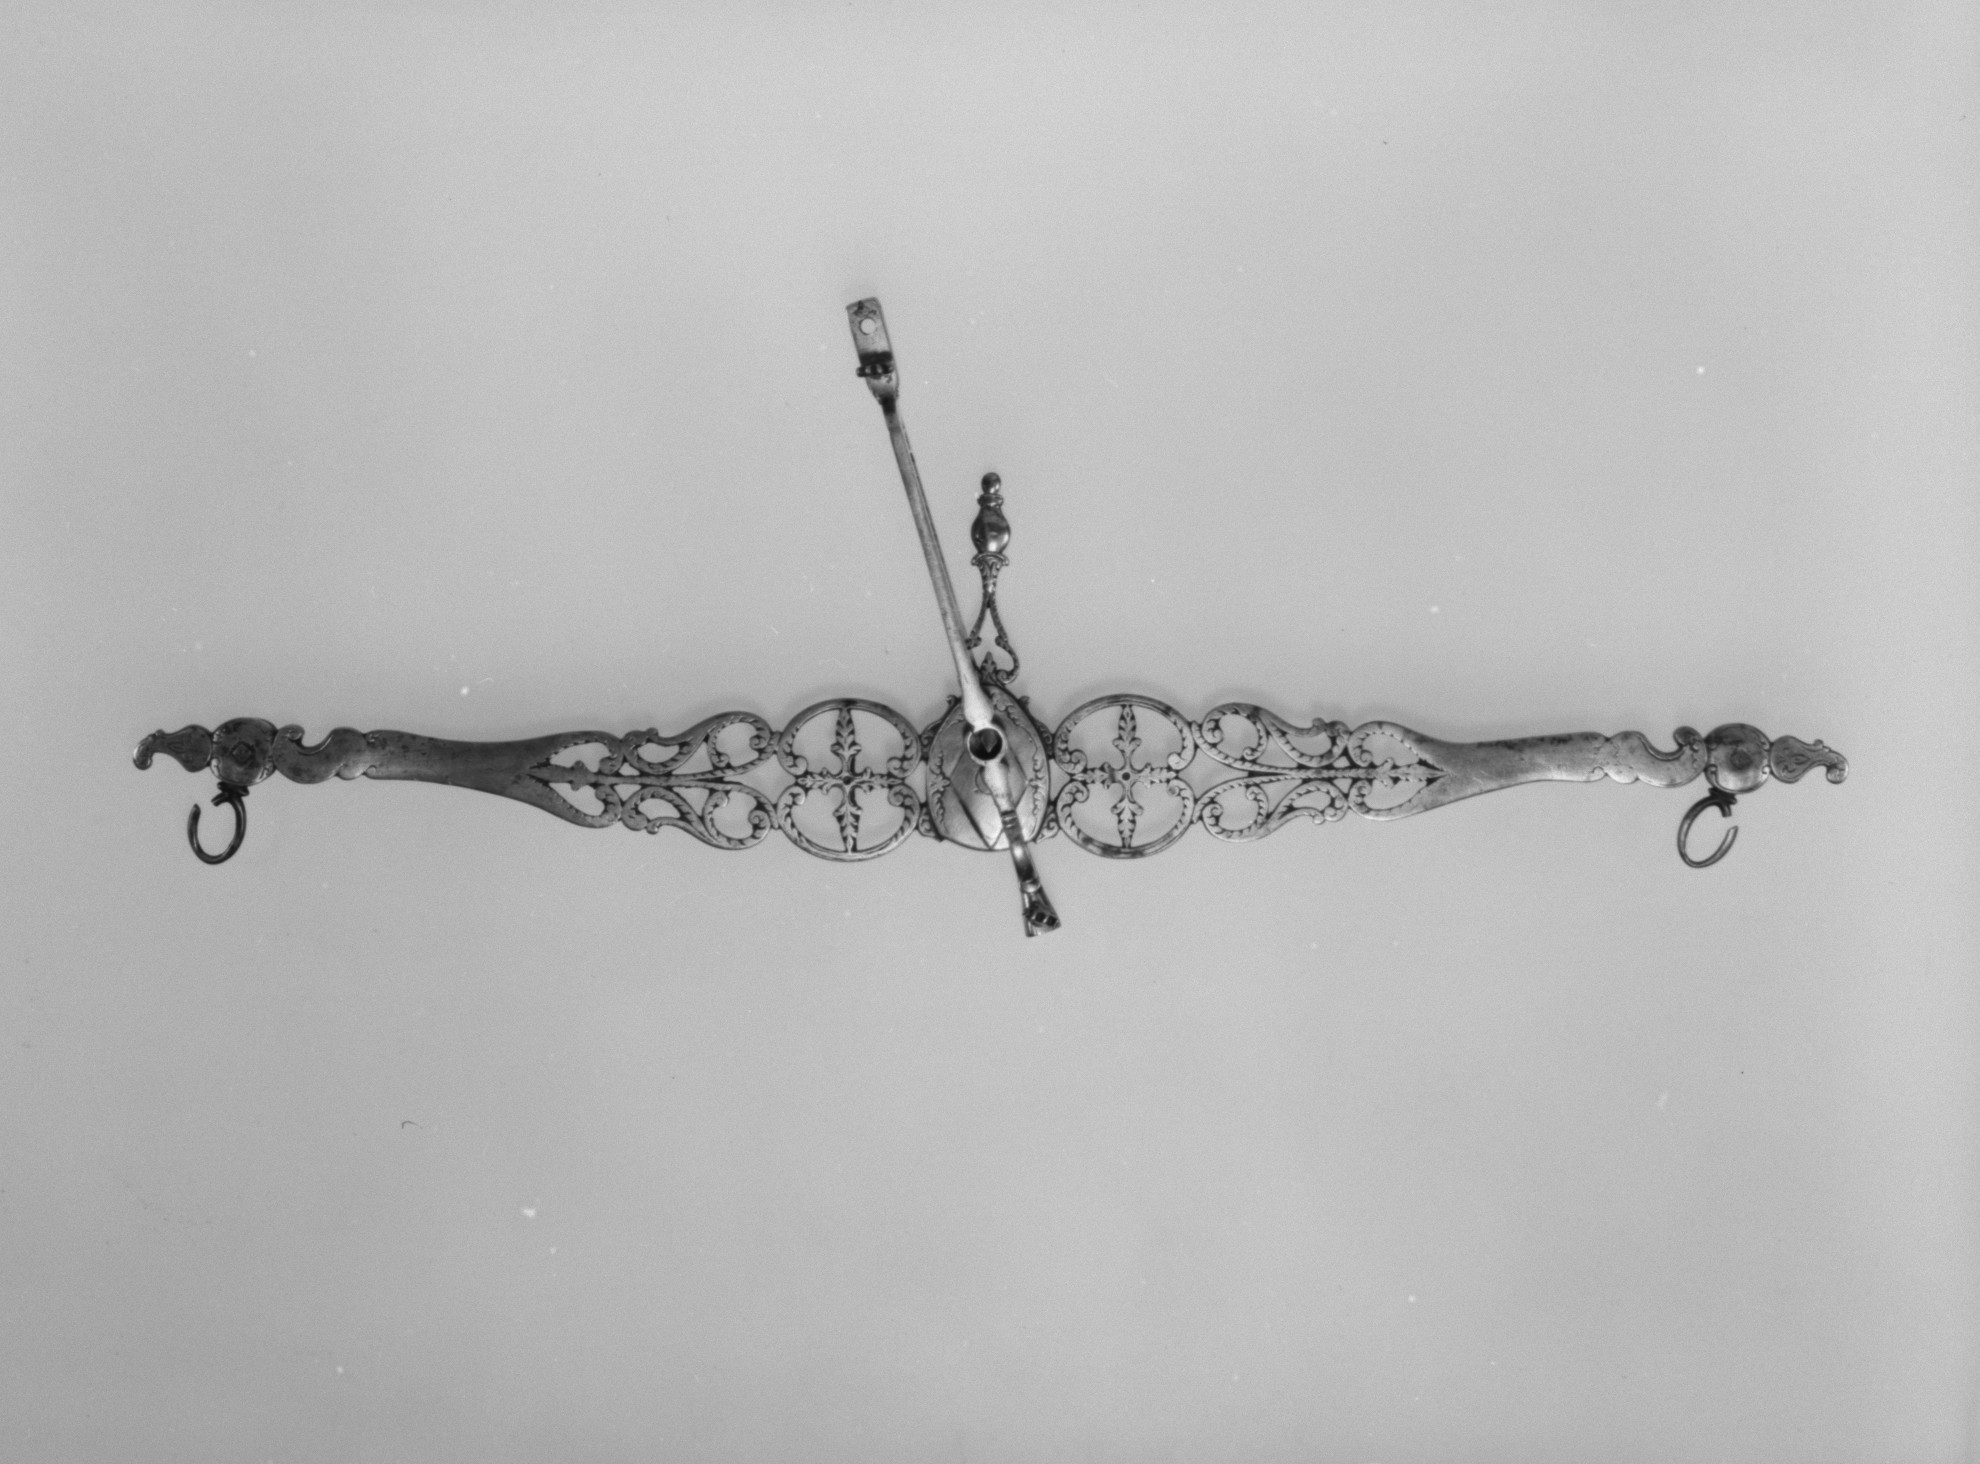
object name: scale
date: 1601-1700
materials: brass, steel